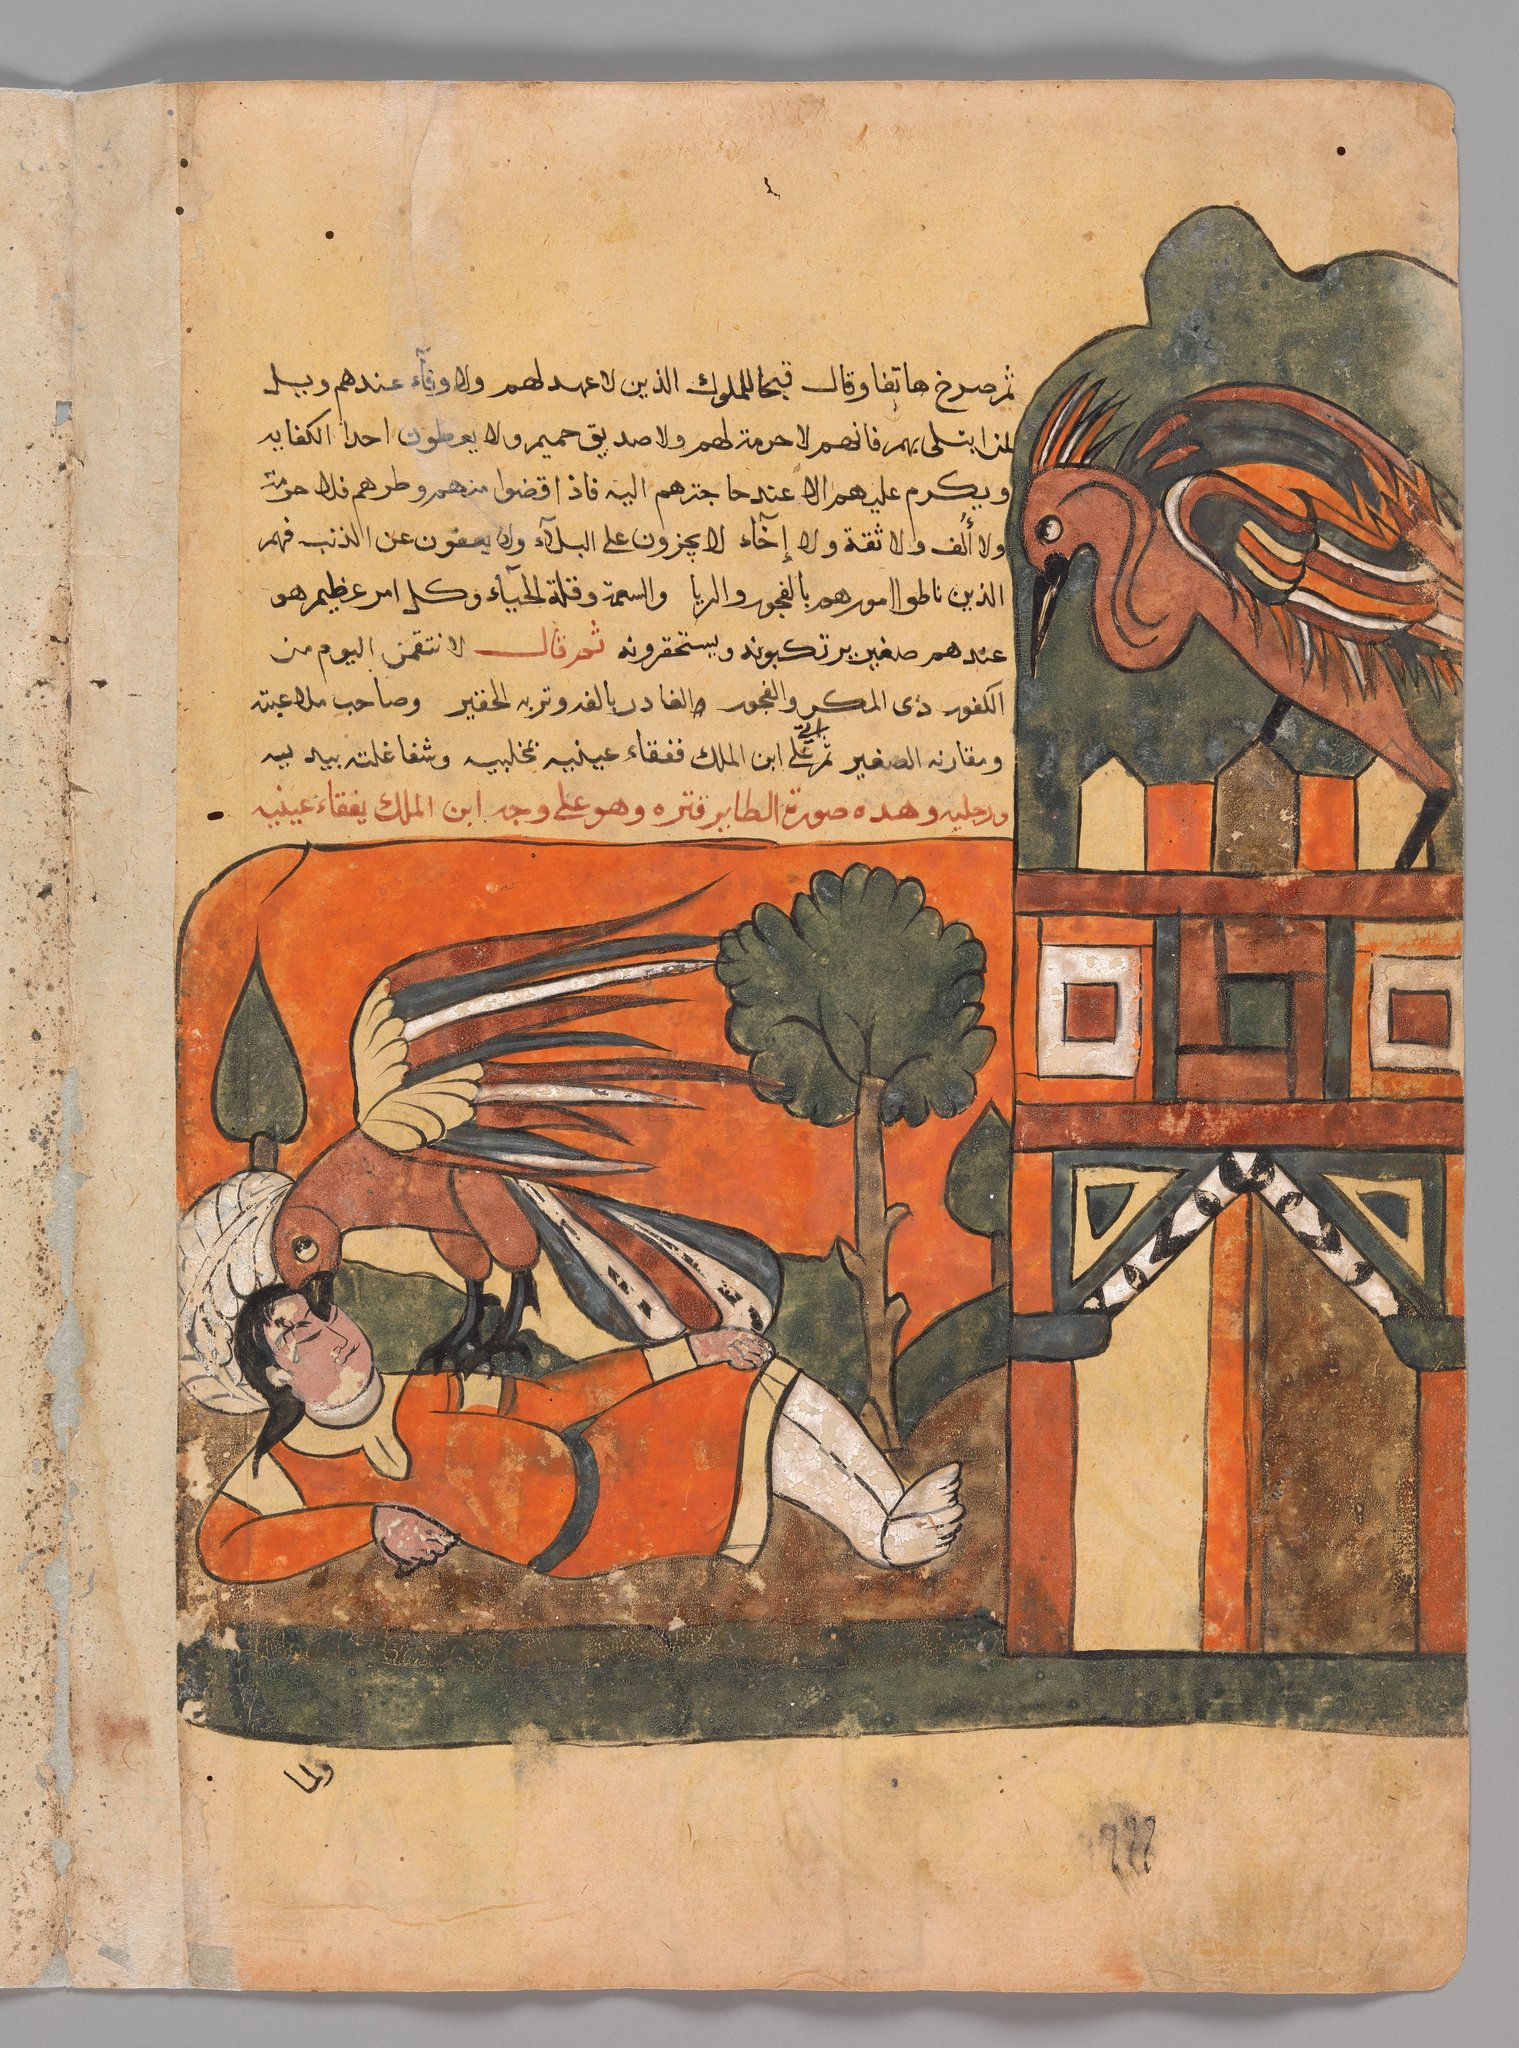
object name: folio from an illustrated manuscript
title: "The Parent Bird Blinds the Prince in Revenge for the Death of her Young One", Folio from a Kalila wa Dimna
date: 1526-1550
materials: ink, paper, watercolor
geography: india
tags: birds,princes